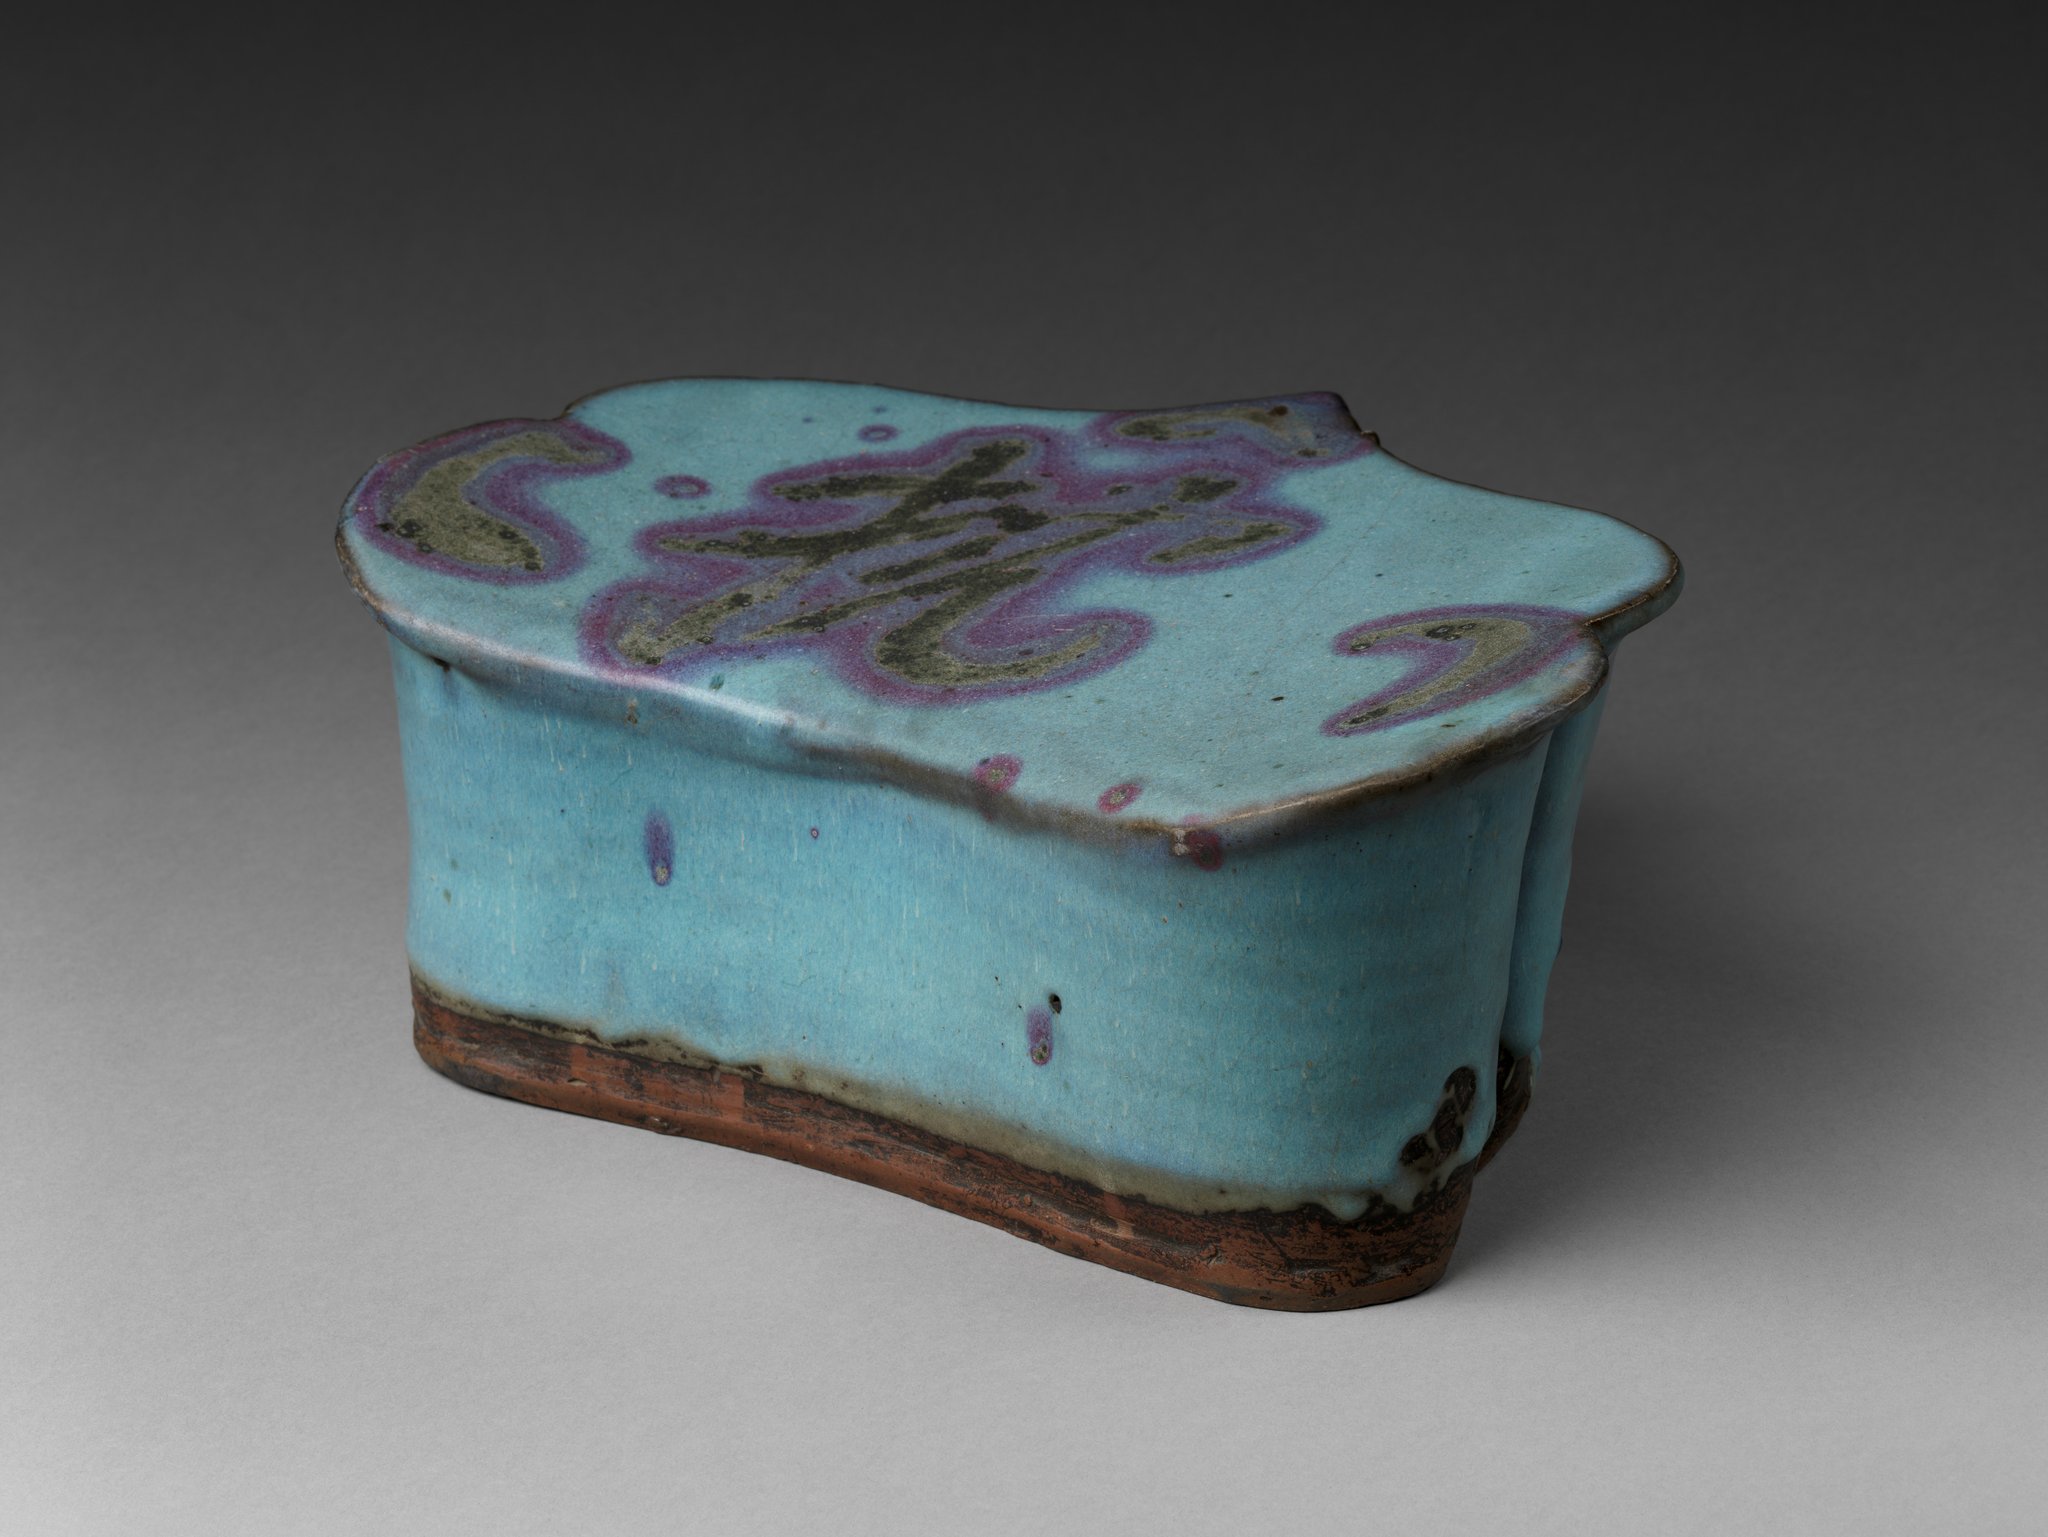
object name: pillow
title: Pillow with Character Reading Zhen (Pillow)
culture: chinese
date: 1101-1300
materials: glaze, stoneware